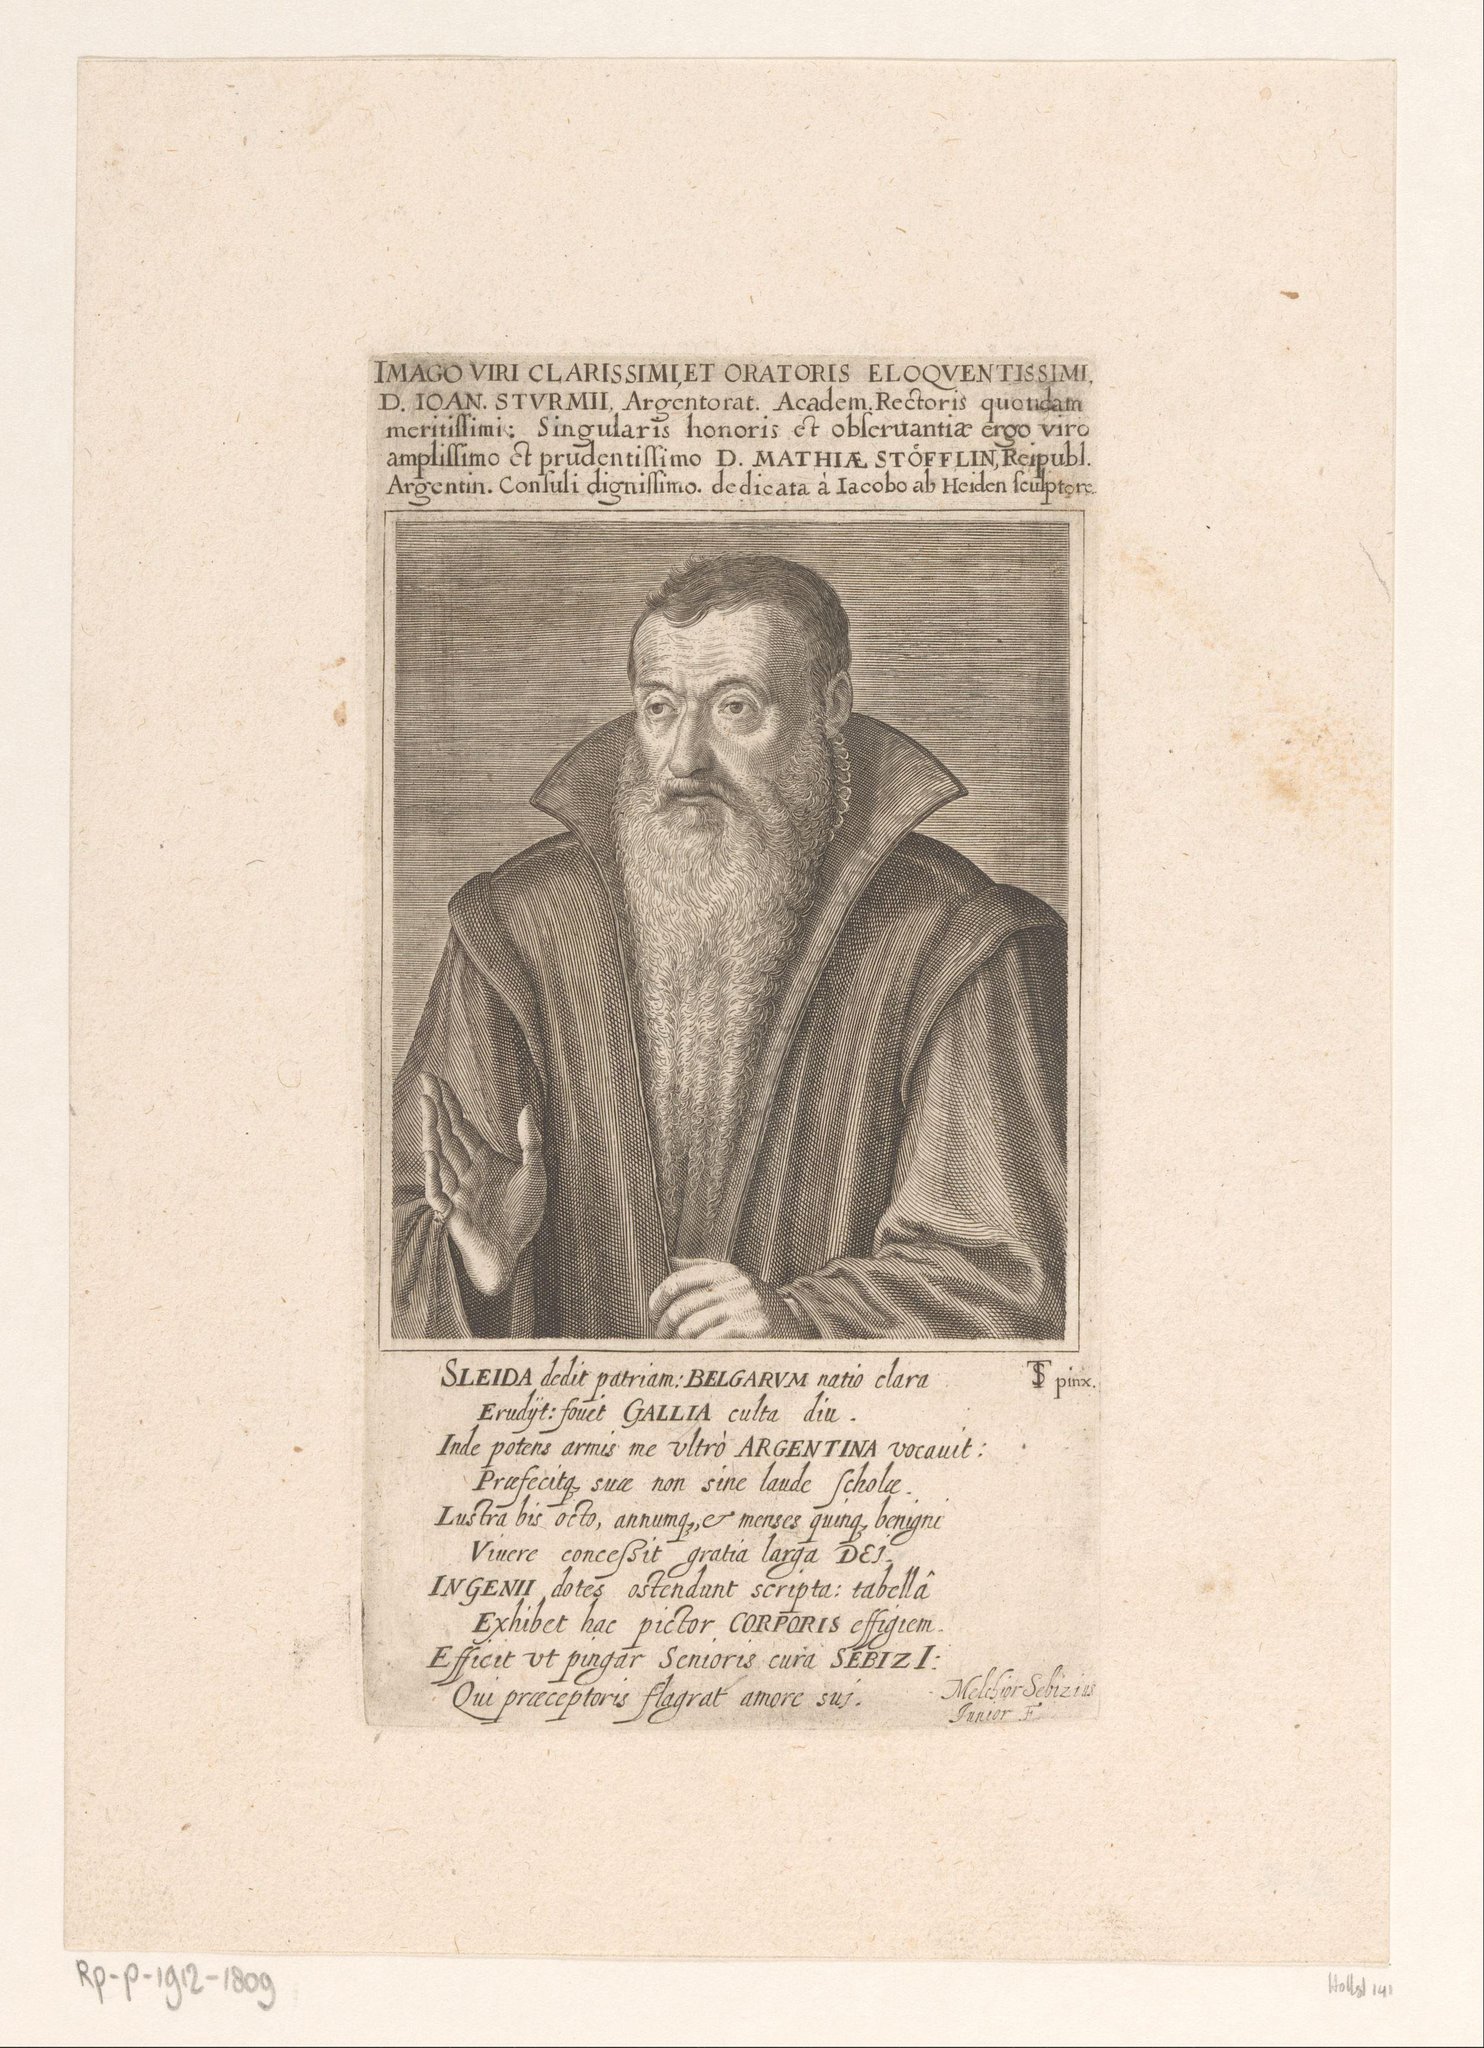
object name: print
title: Portret van Johann Sturm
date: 1583-1645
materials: paper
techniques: engraving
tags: historical persons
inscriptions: collector's mark: Lugt 2228